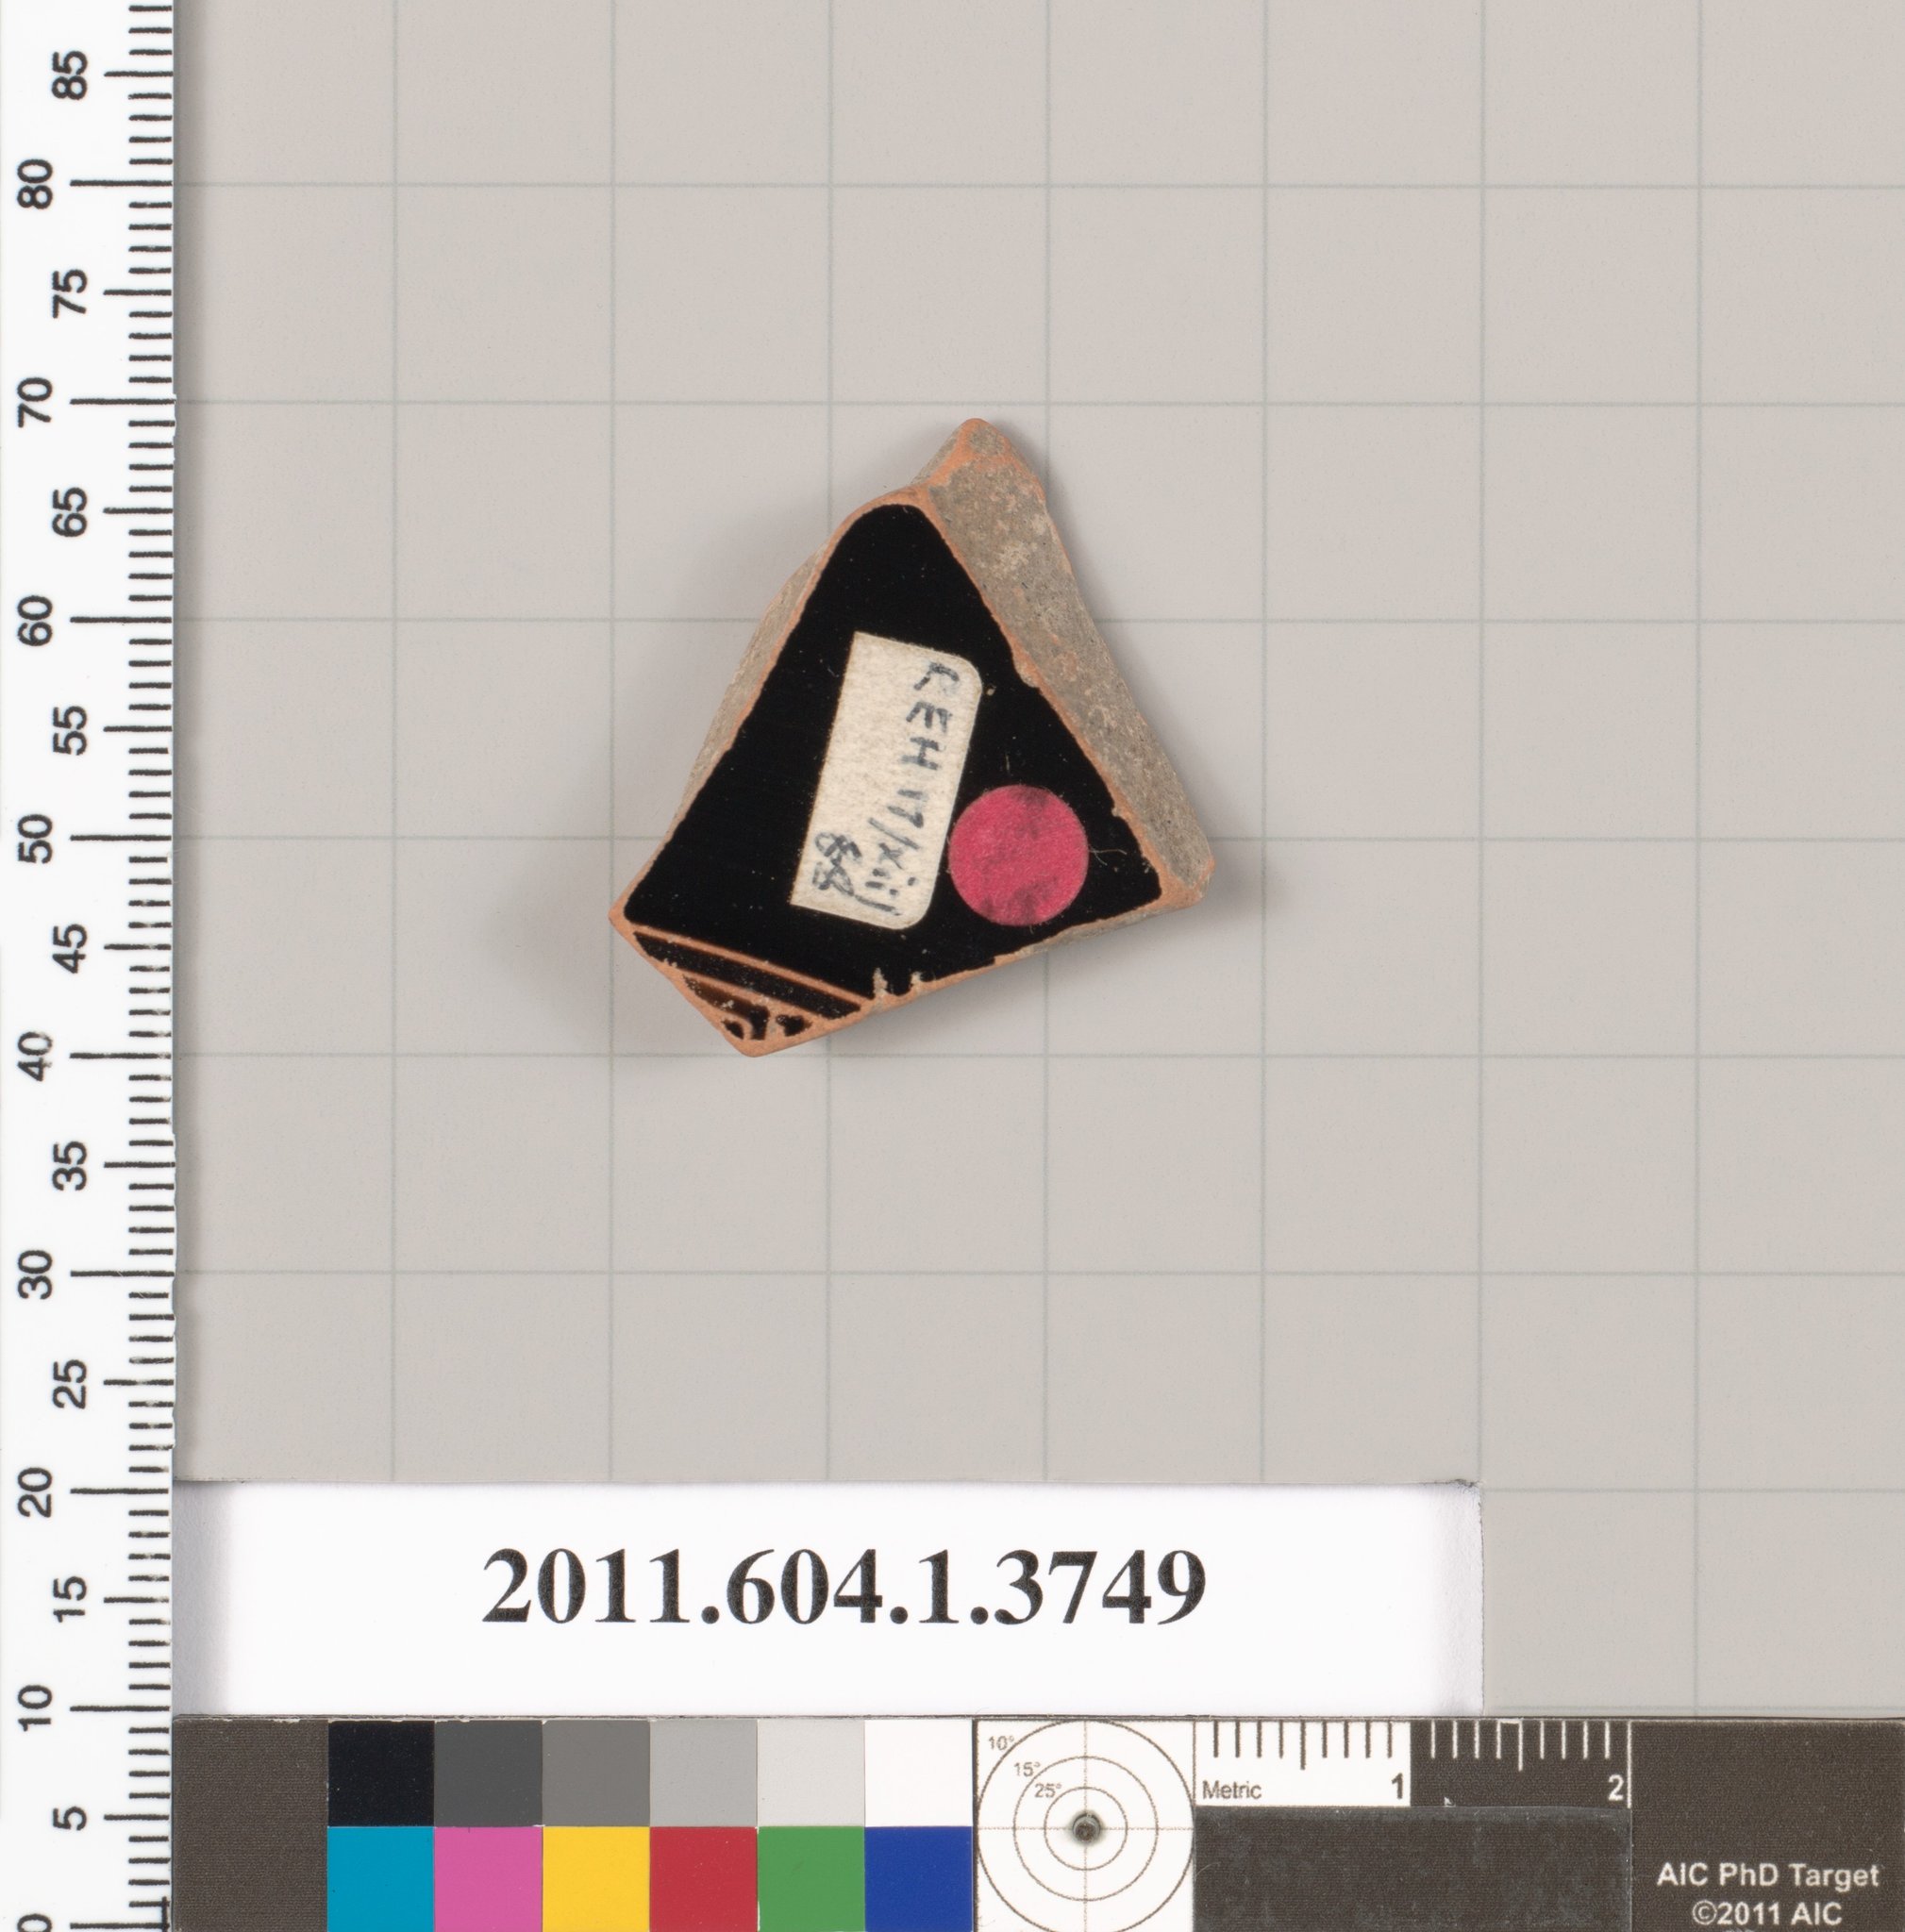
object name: kylix fragment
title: Terracotta fragment of a kylix (drinking cup)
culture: greek, attic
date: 475-451 BCE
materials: terracotta